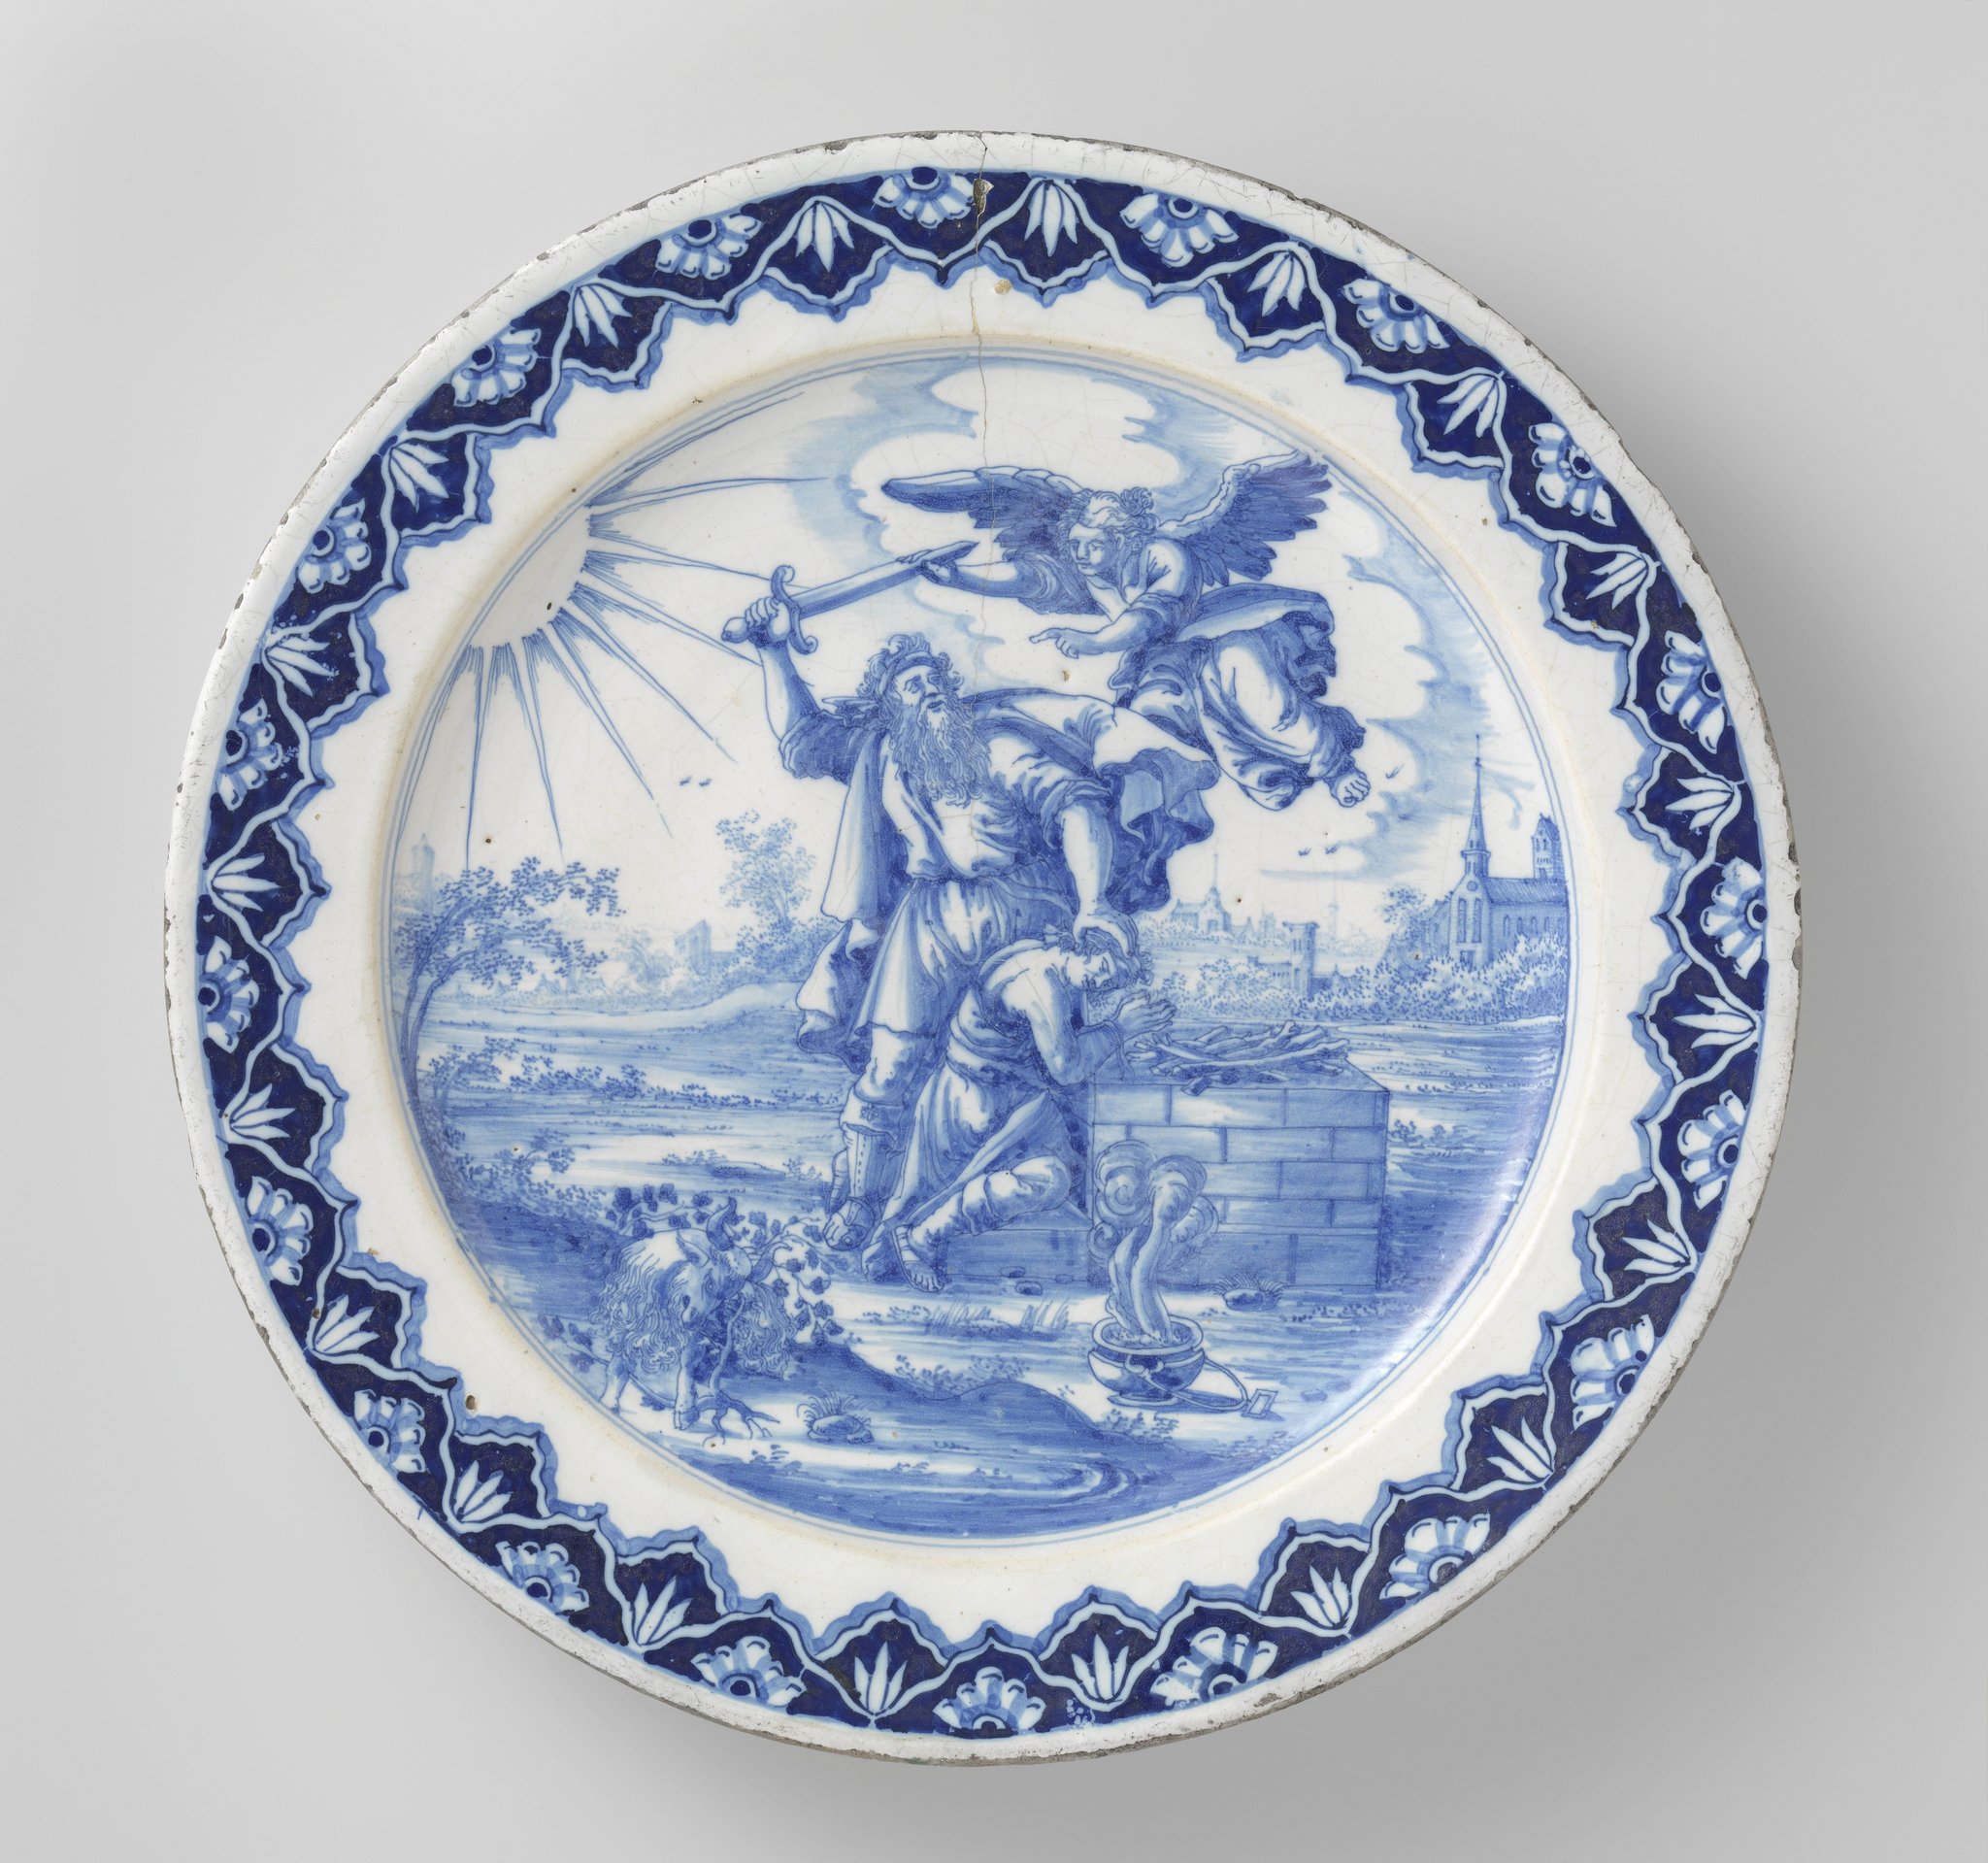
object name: platter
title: Dish with the Sacrifice of Abraham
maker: willem jansz. verstraeten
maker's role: plateelbakker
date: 1650-1660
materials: faience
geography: antwerp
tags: when abraham has his hand raised to kill isaac, an angel restrains abraham's hand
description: Schotel van faience met het offer van Abraham.